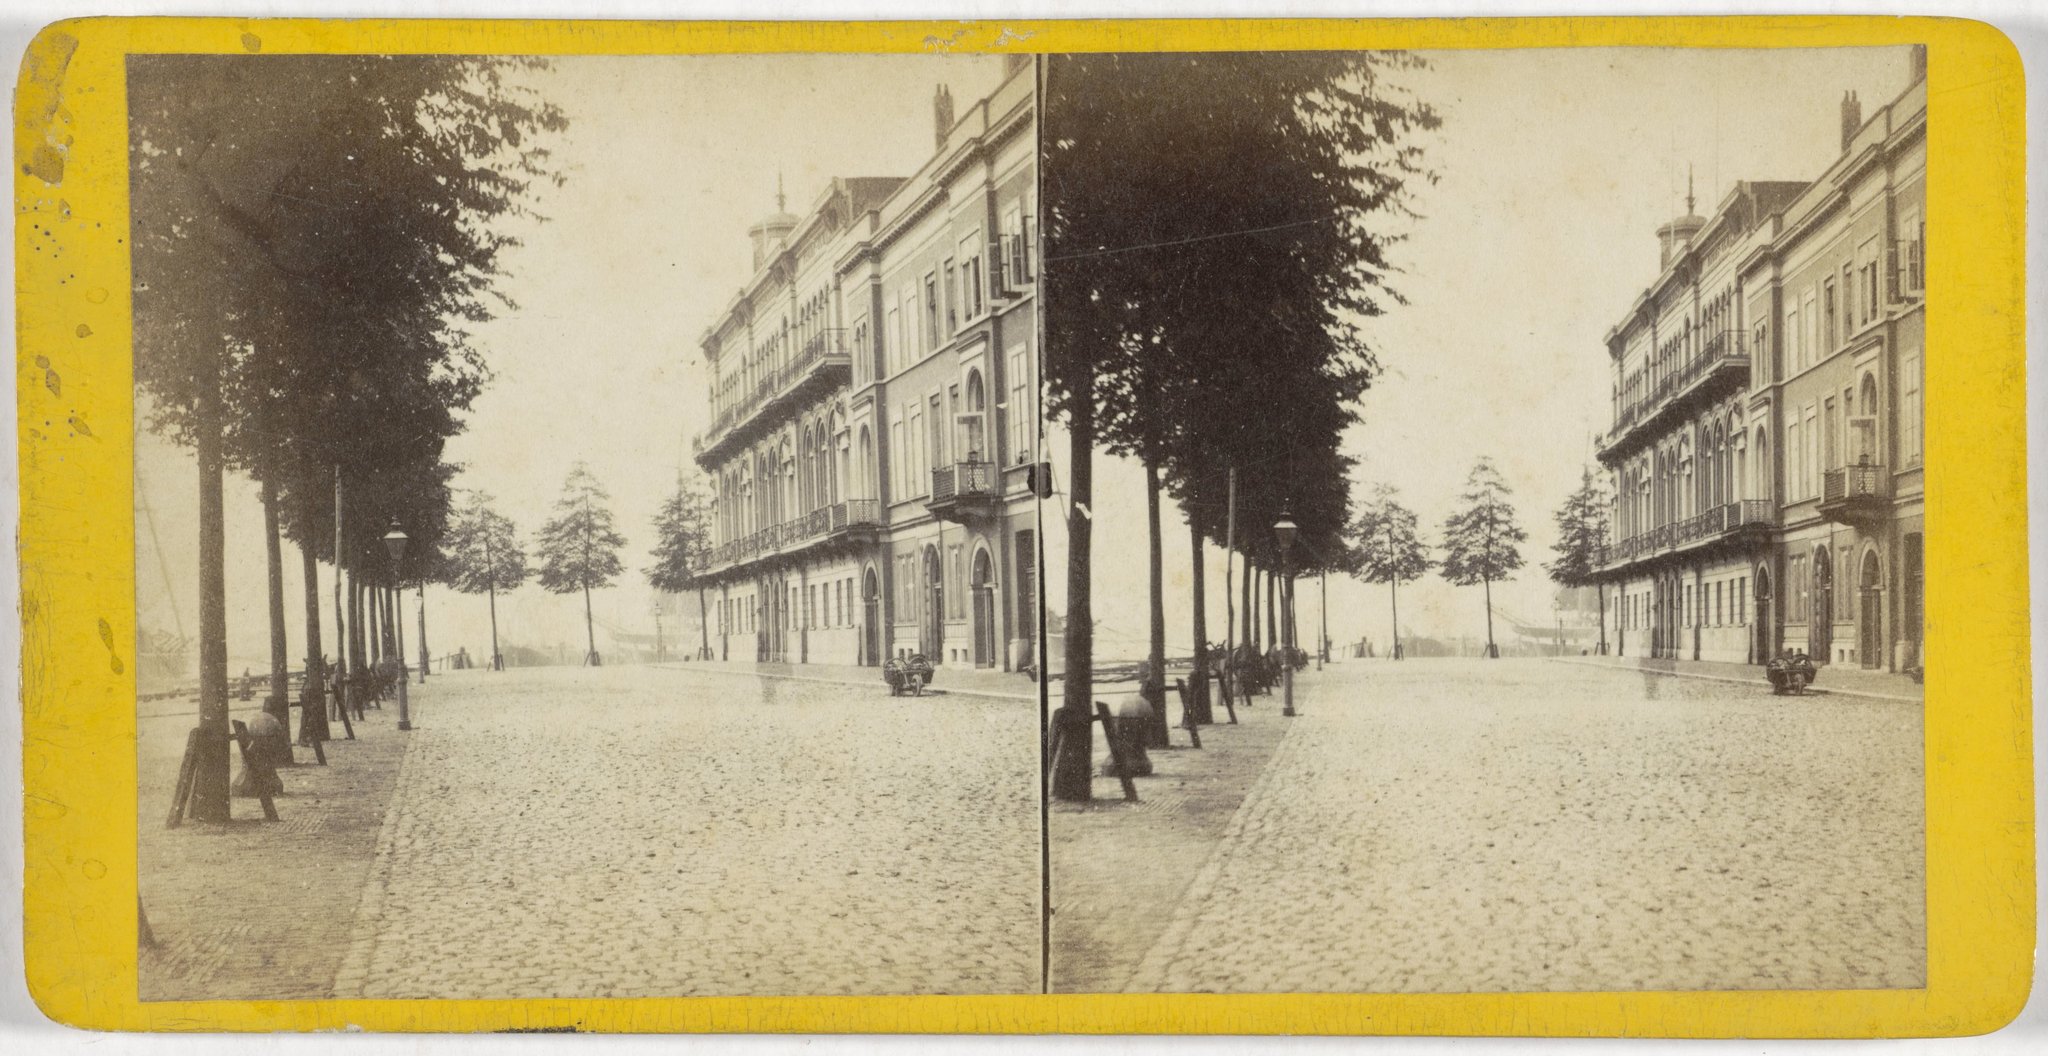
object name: stereograph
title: Yachtclub, Rotterdam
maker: Anonymous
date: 1873-1890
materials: cardboard, paper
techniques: albumen print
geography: rotterdam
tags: urban housing, quay